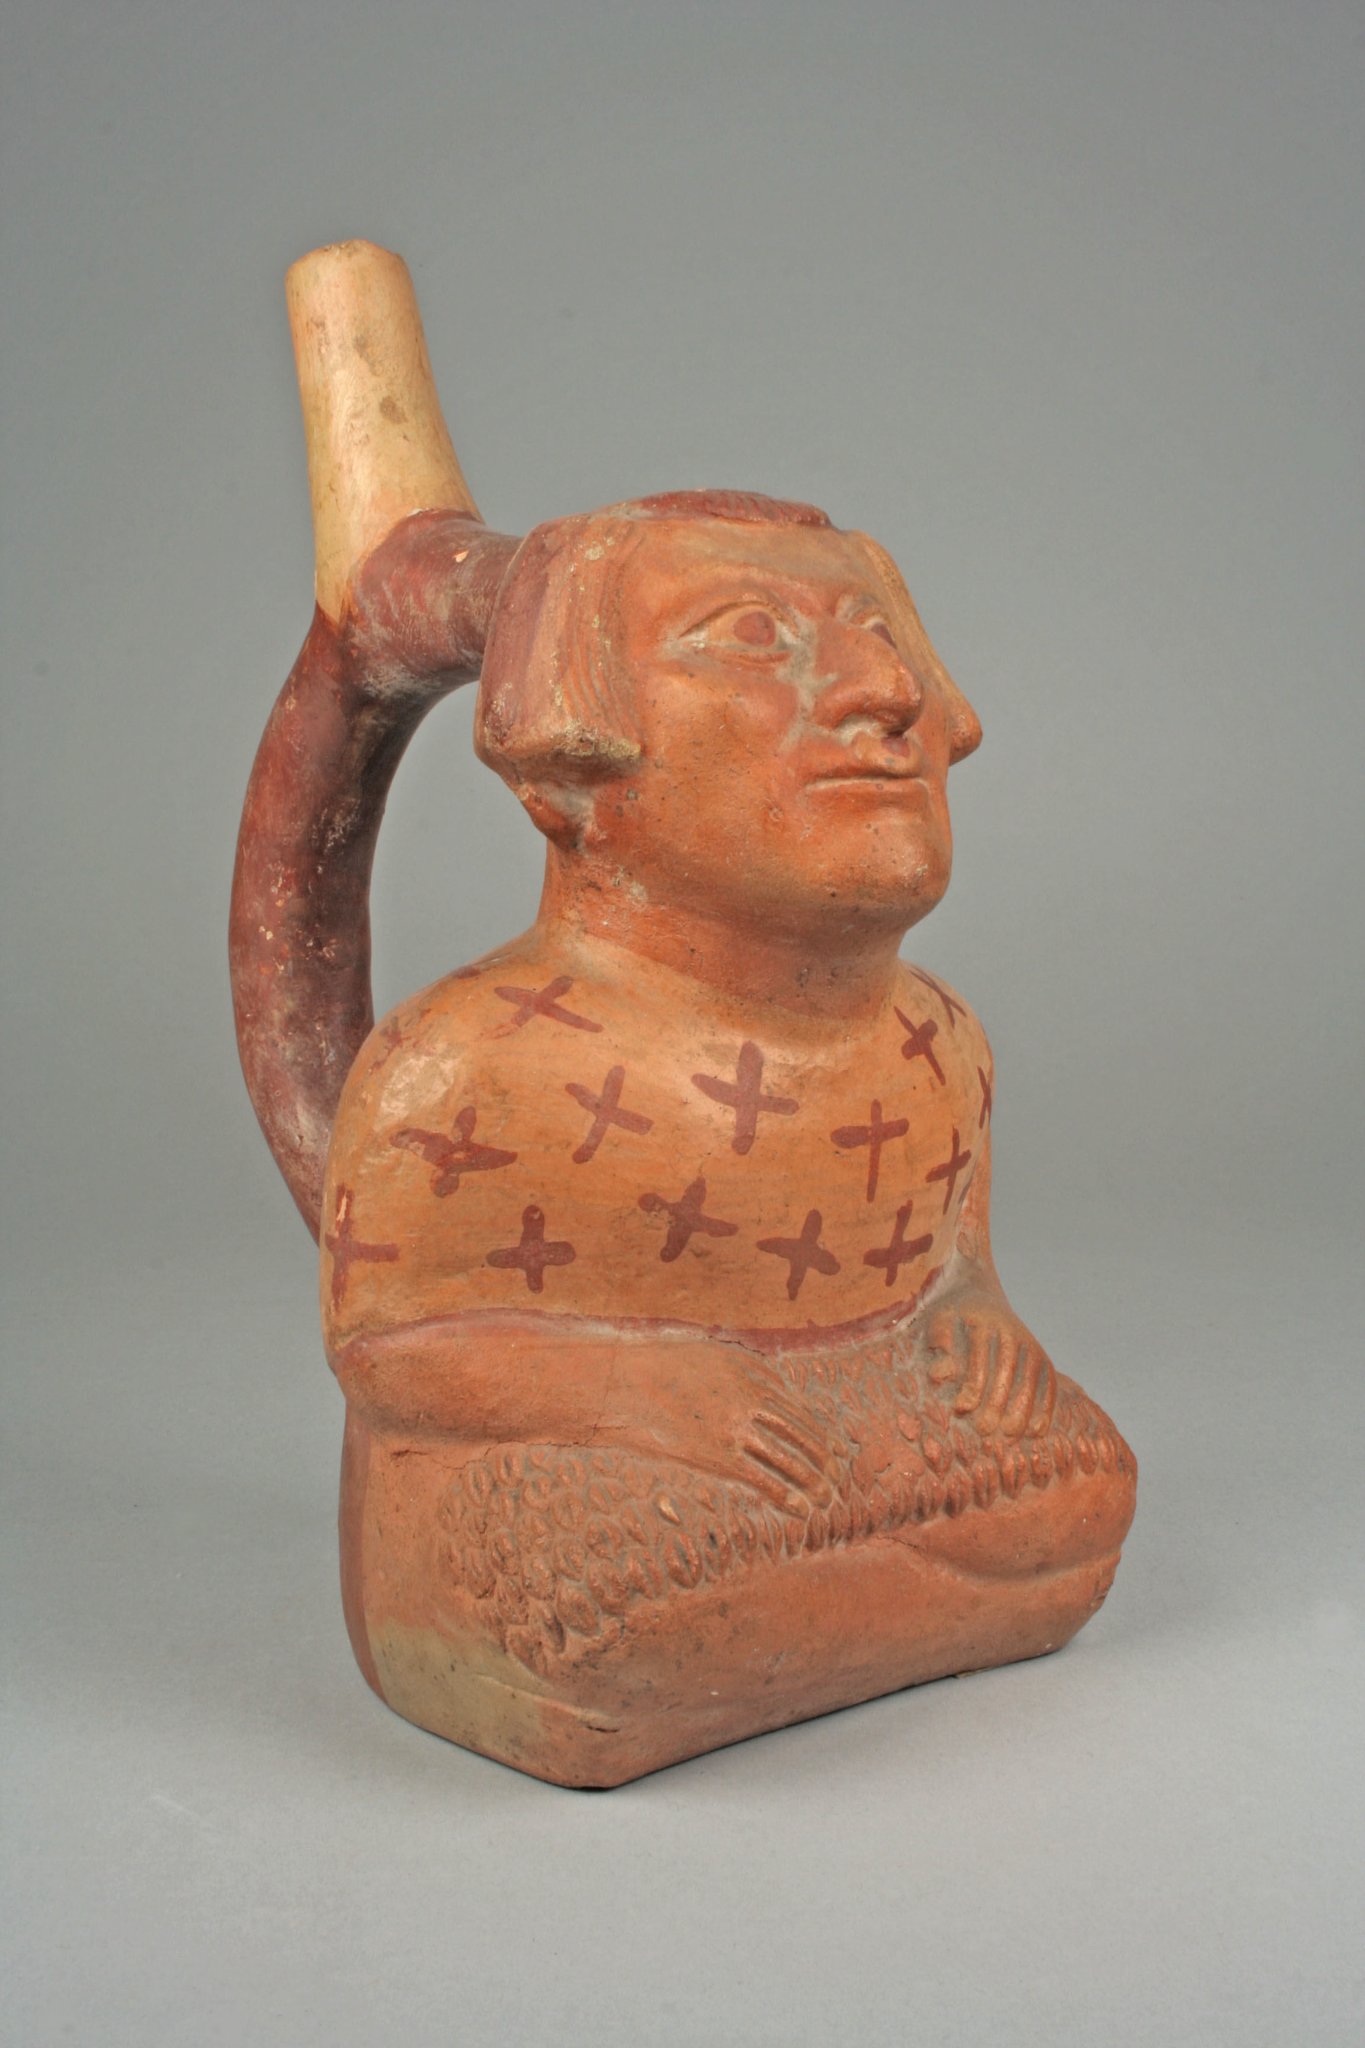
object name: bottle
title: Bottle, Seated Figure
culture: moche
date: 401-700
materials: ceramic, pigment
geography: peru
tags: men